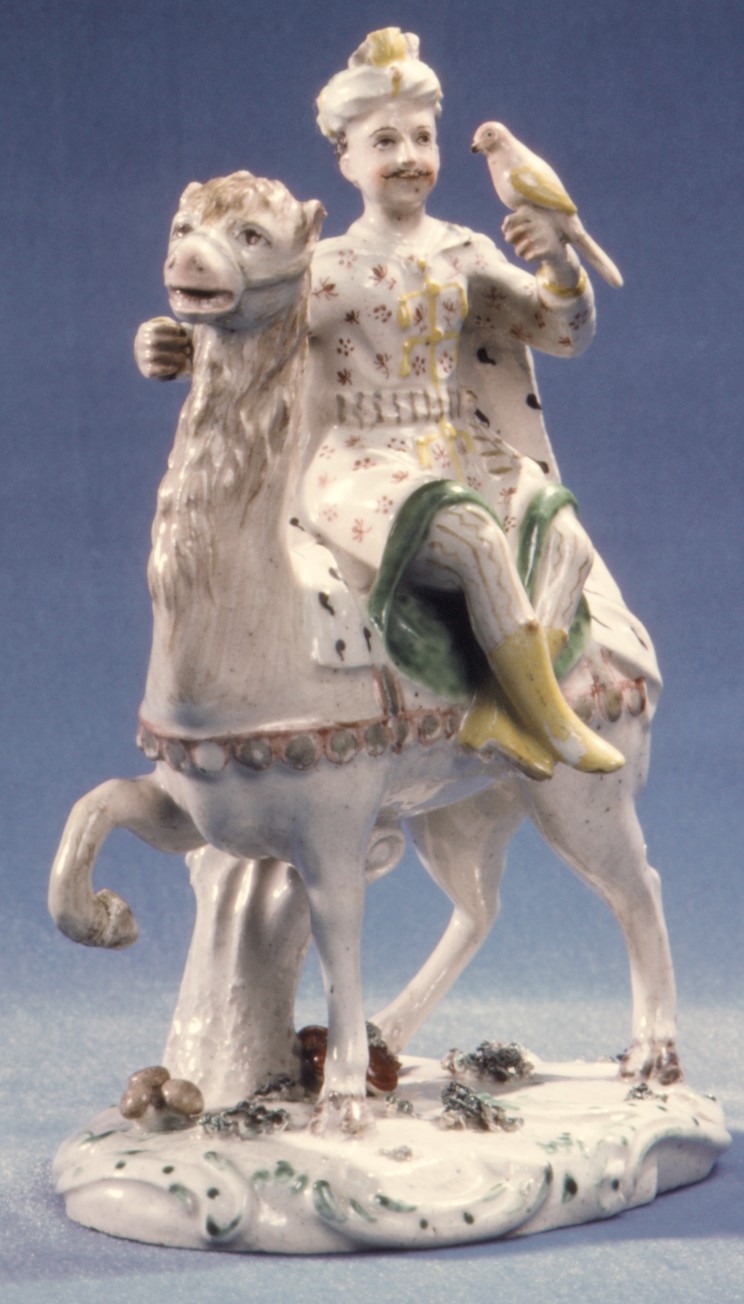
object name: group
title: Turkish ruler seated upon a dromedary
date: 1772-1774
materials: earthenware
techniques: glazing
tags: birds,kings,camels